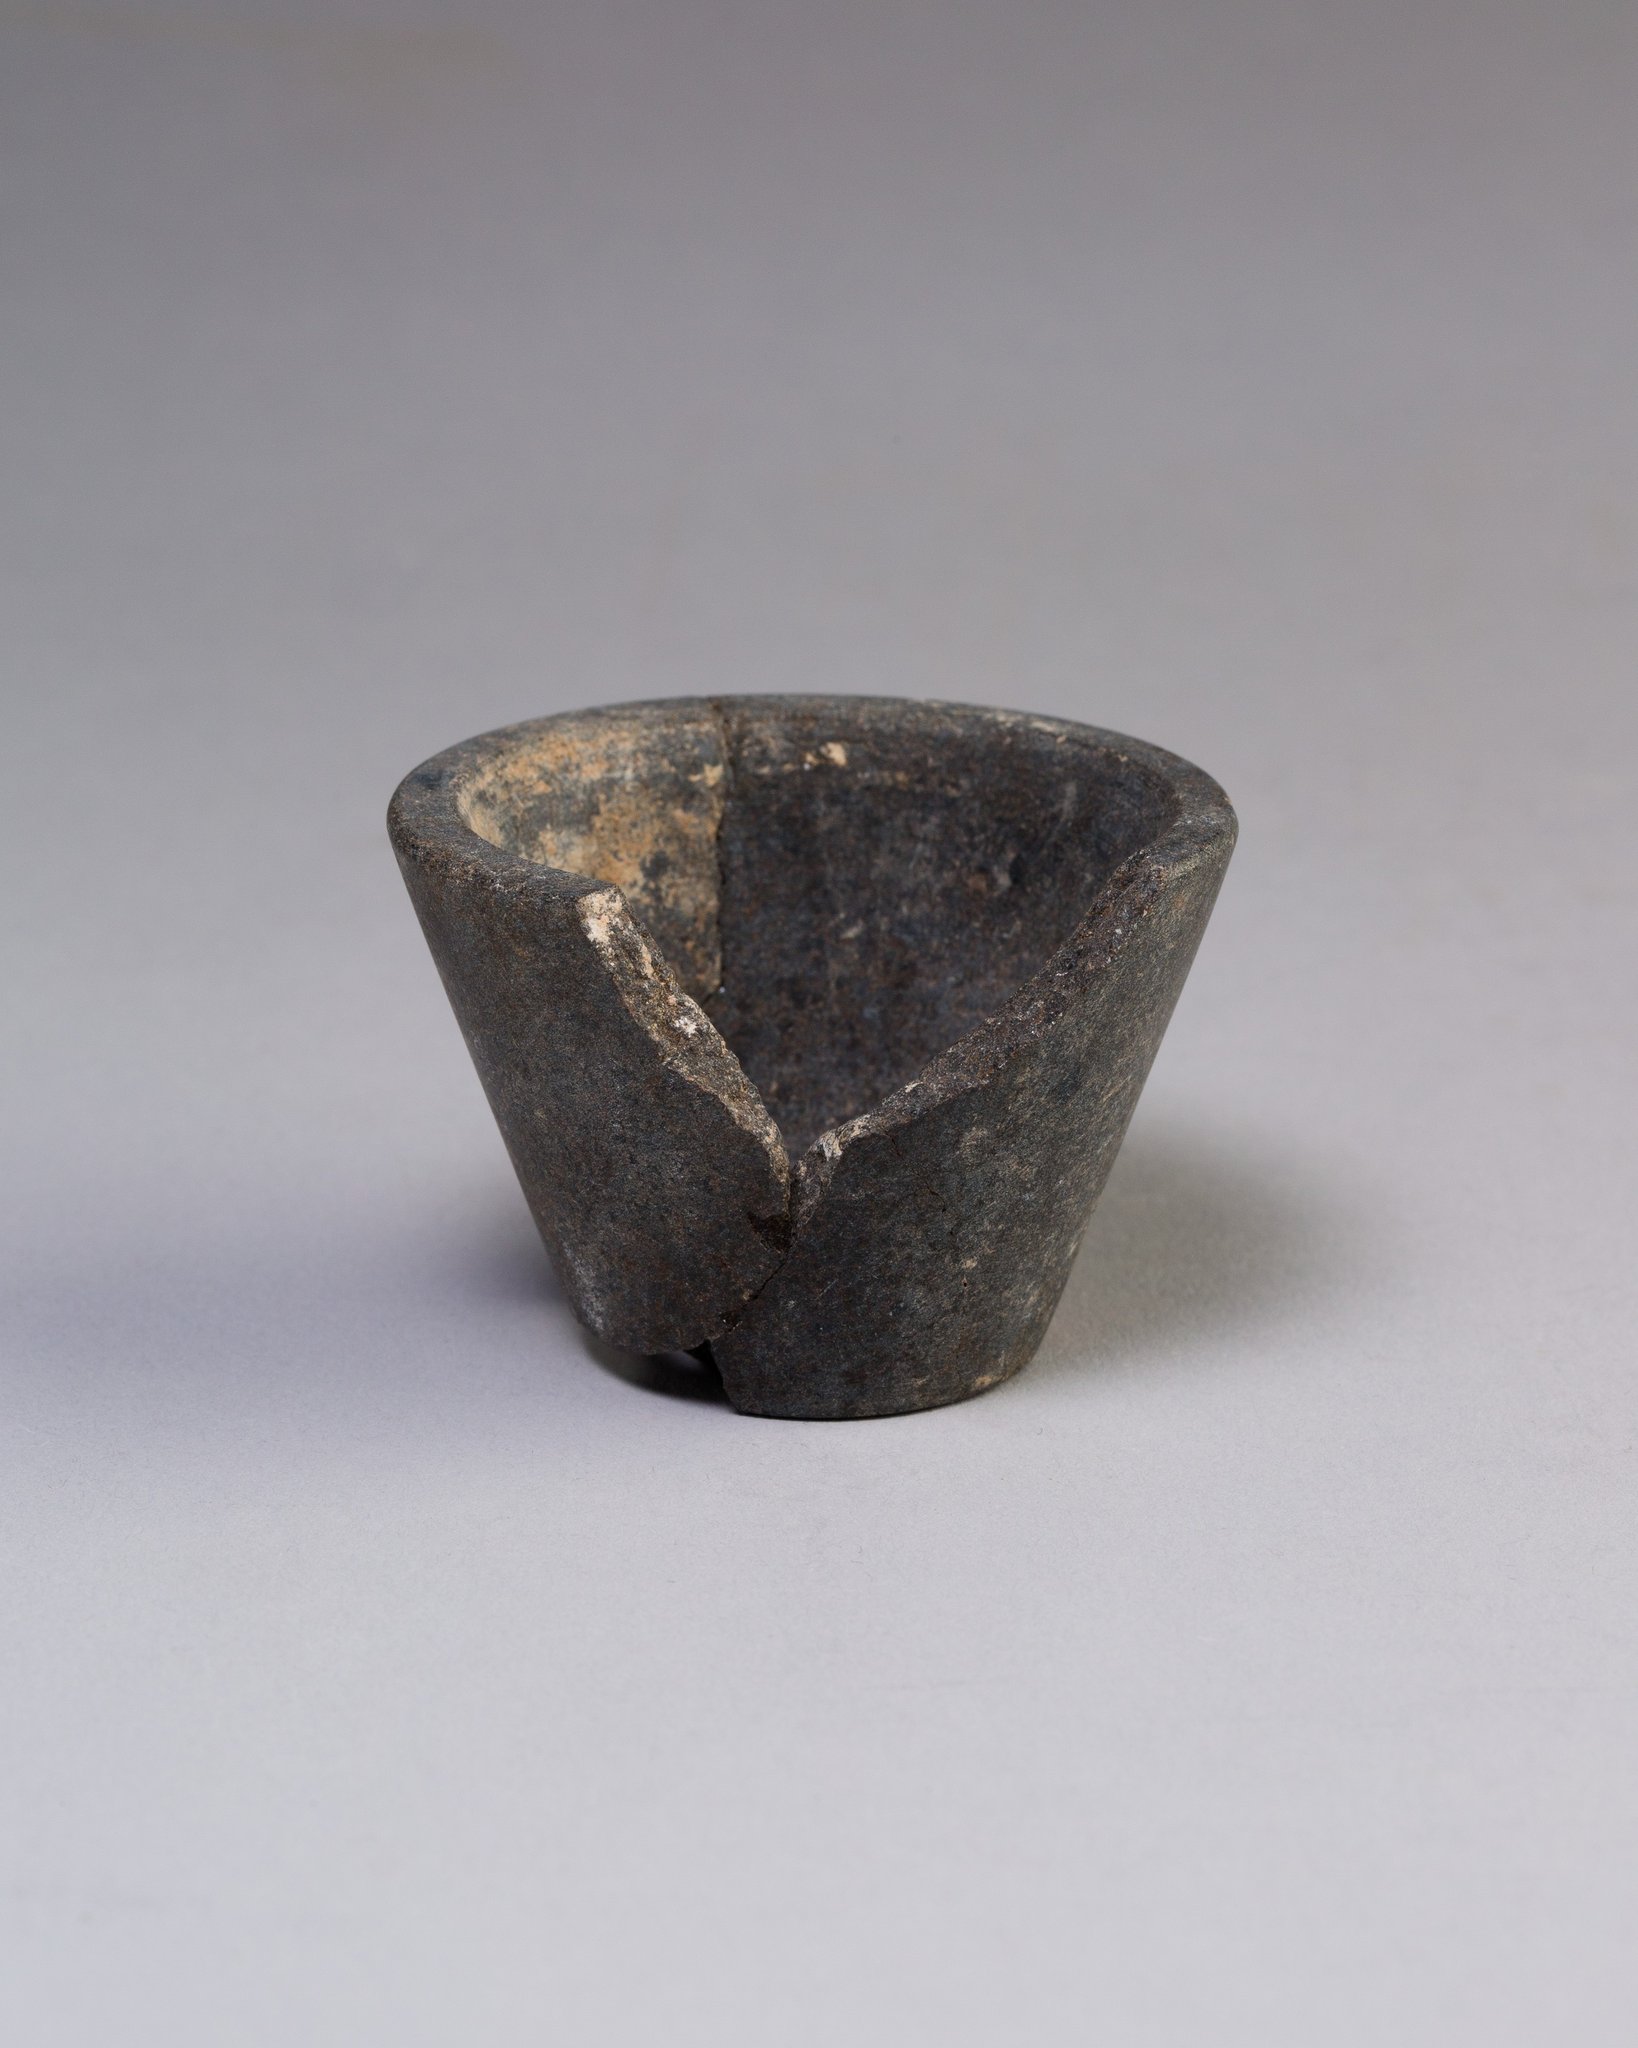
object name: vessel, opening of the mouth, perneb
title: "Opening of the Mouth" vessel of Perneb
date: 2381-2323 BCE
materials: stone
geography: egypt